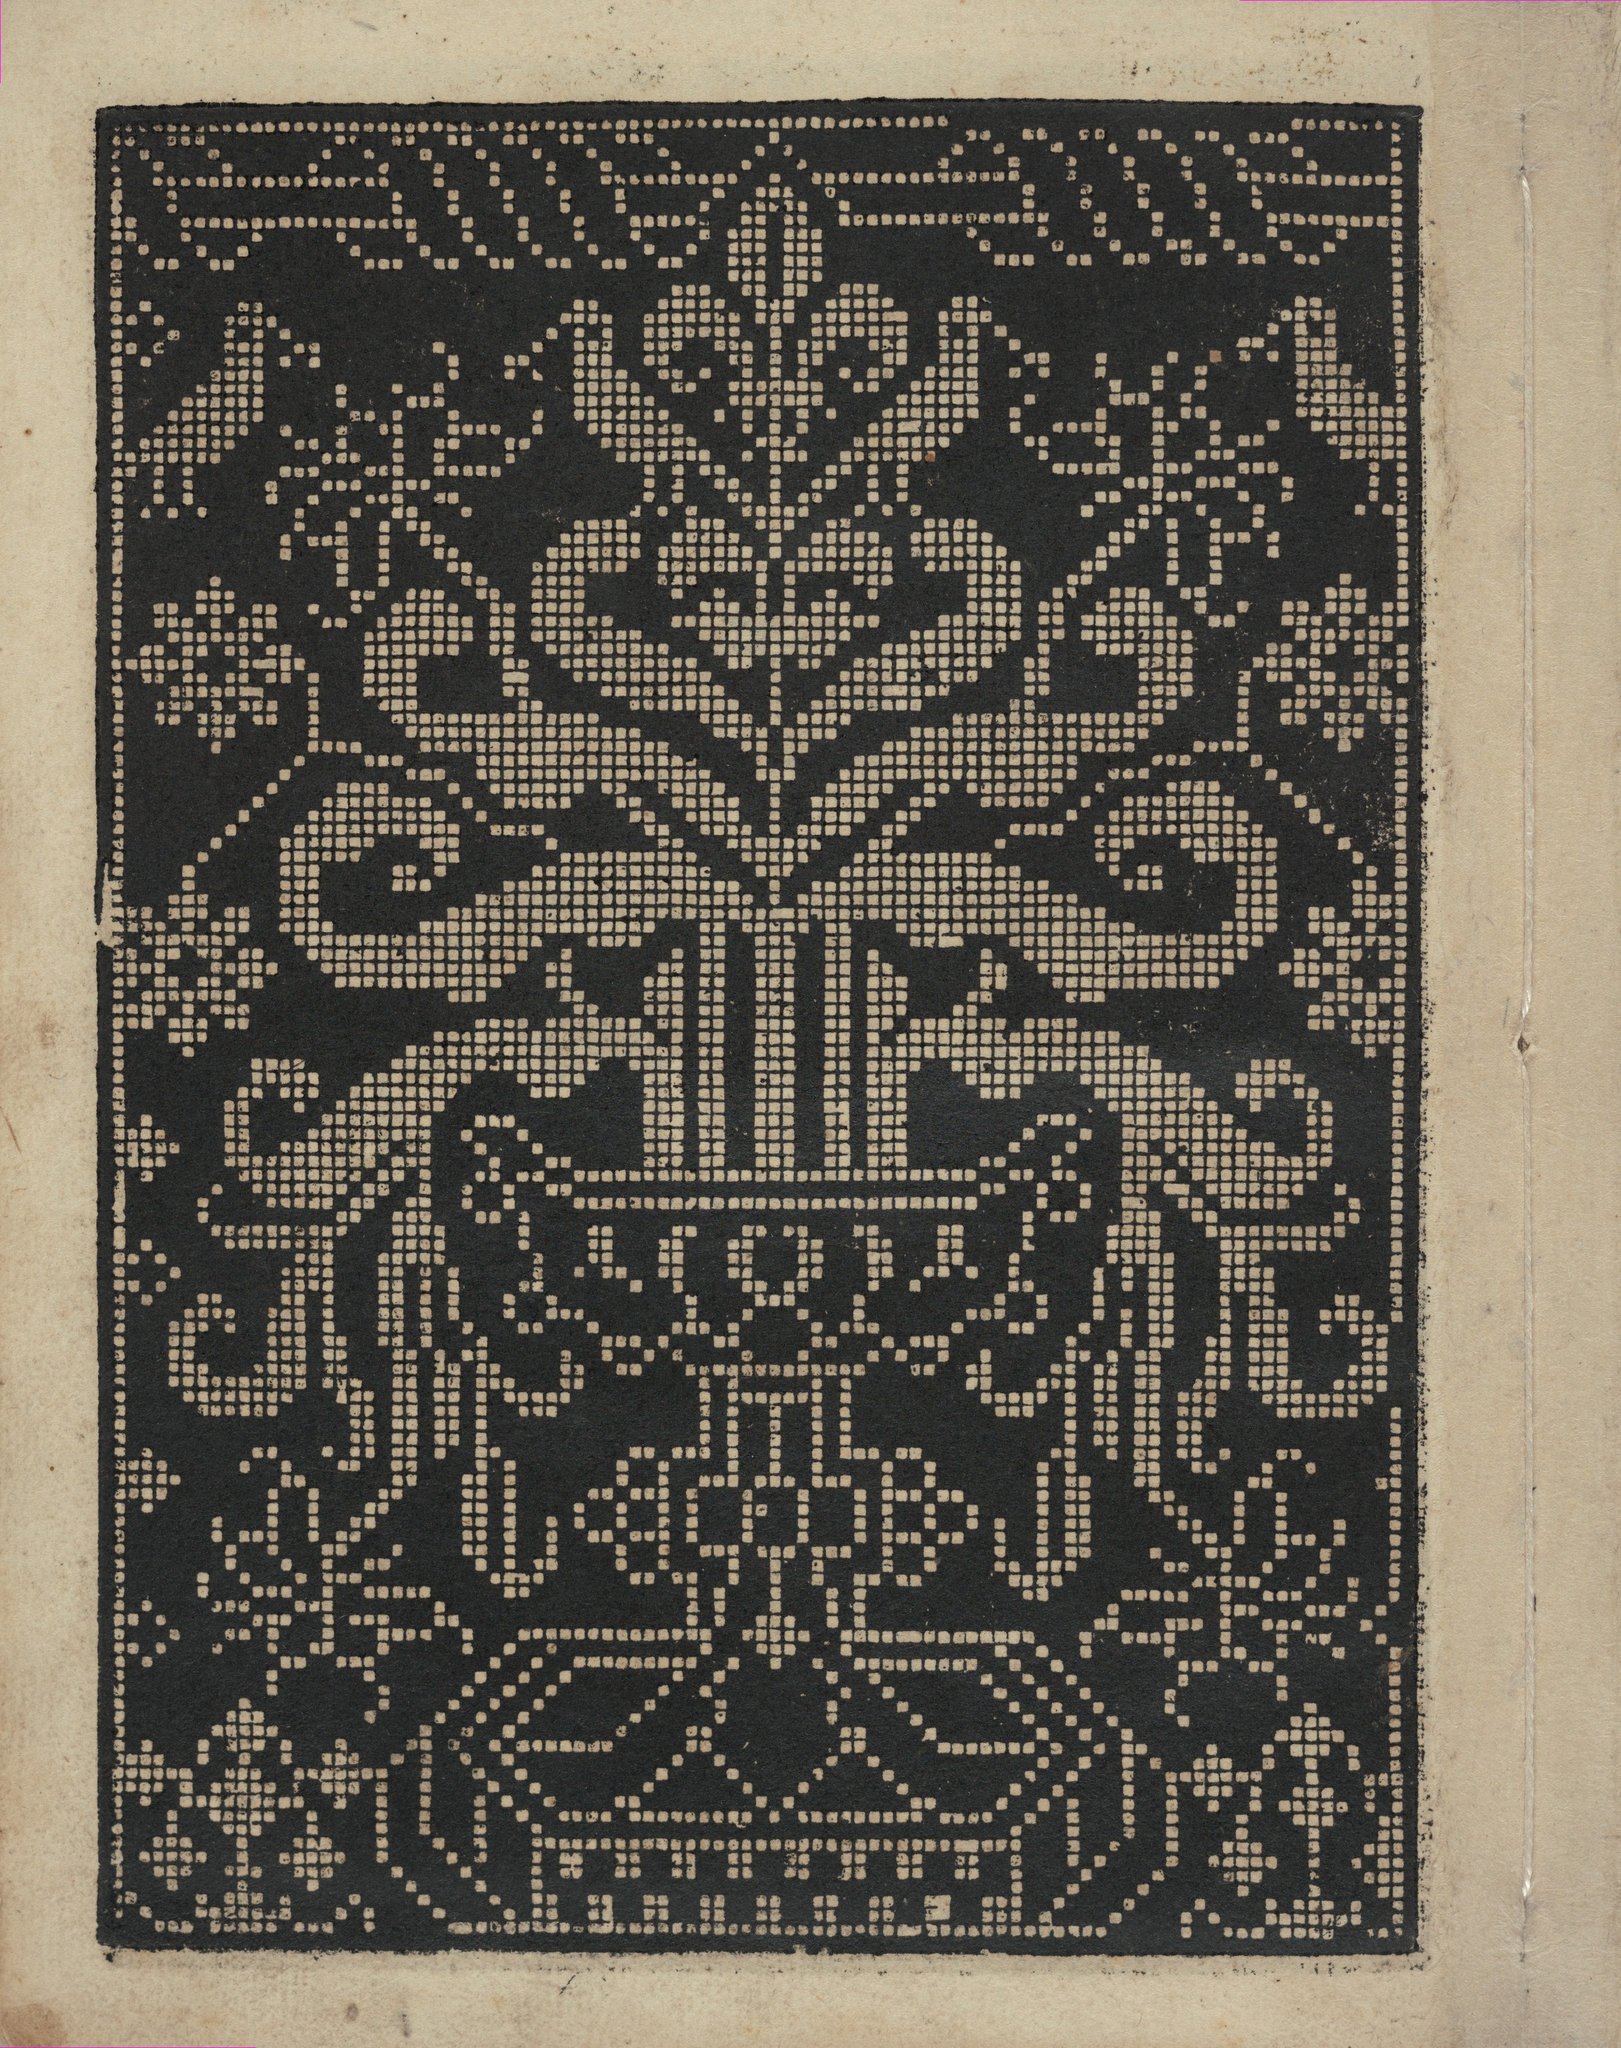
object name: book print ornament architecture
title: Libbretto nouellamete composto per maestro Domenico da Sera...lauorare di ogni sorte di punti, page 11 (verso)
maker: domenico da sera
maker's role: publisher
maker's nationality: french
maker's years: 1500-1599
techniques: woodcut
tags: birds,plants,vases